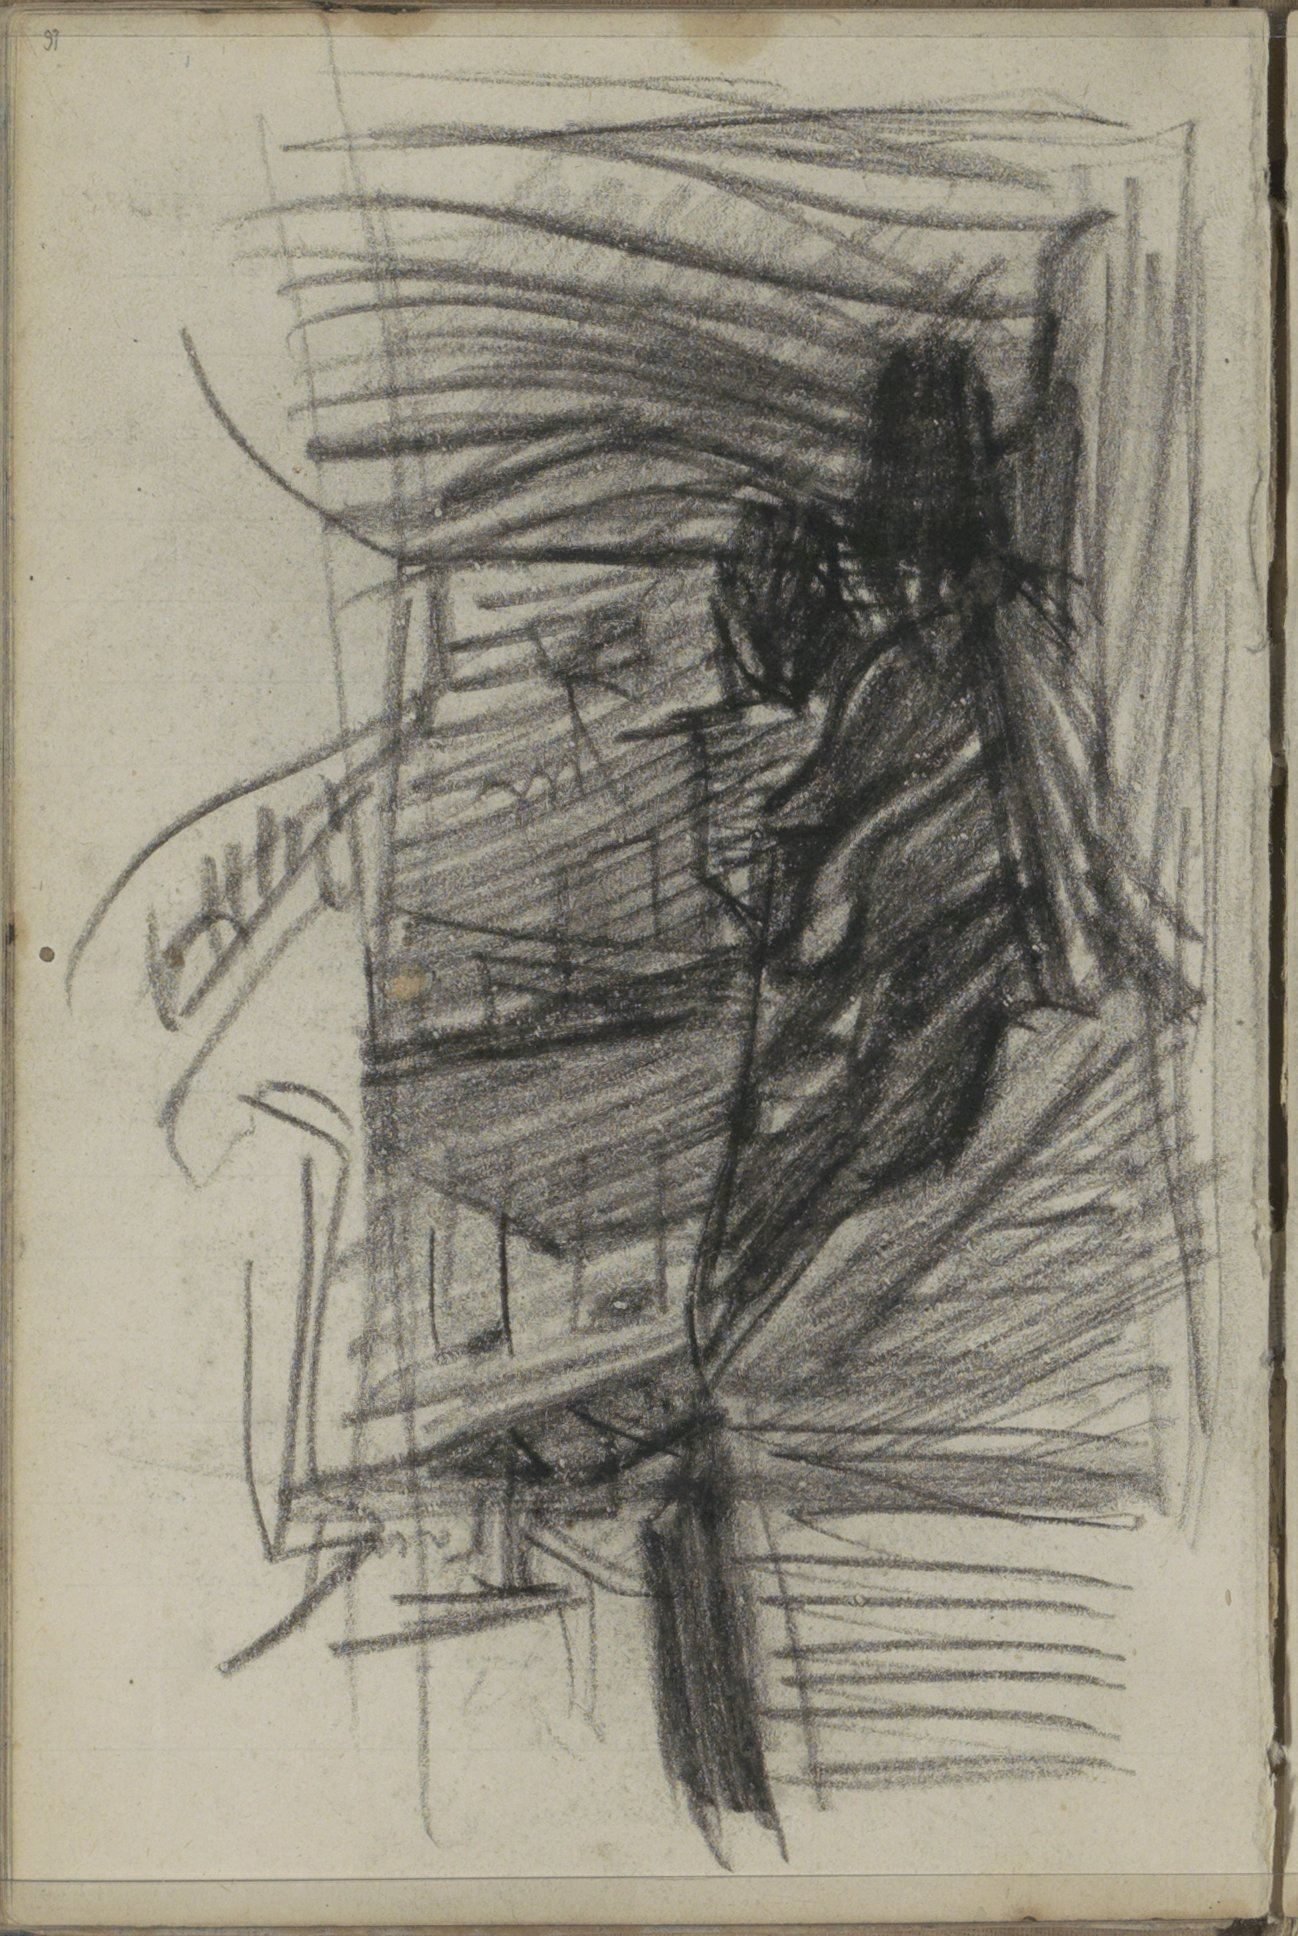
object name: sketchbook leaf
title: Studieblad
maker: marius bauer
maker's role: draughtsman, print maker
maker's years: 1867-1932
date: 1888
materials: chalk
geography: istanbul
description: Pagina 97 uit een schetsboek met 58 bladen.